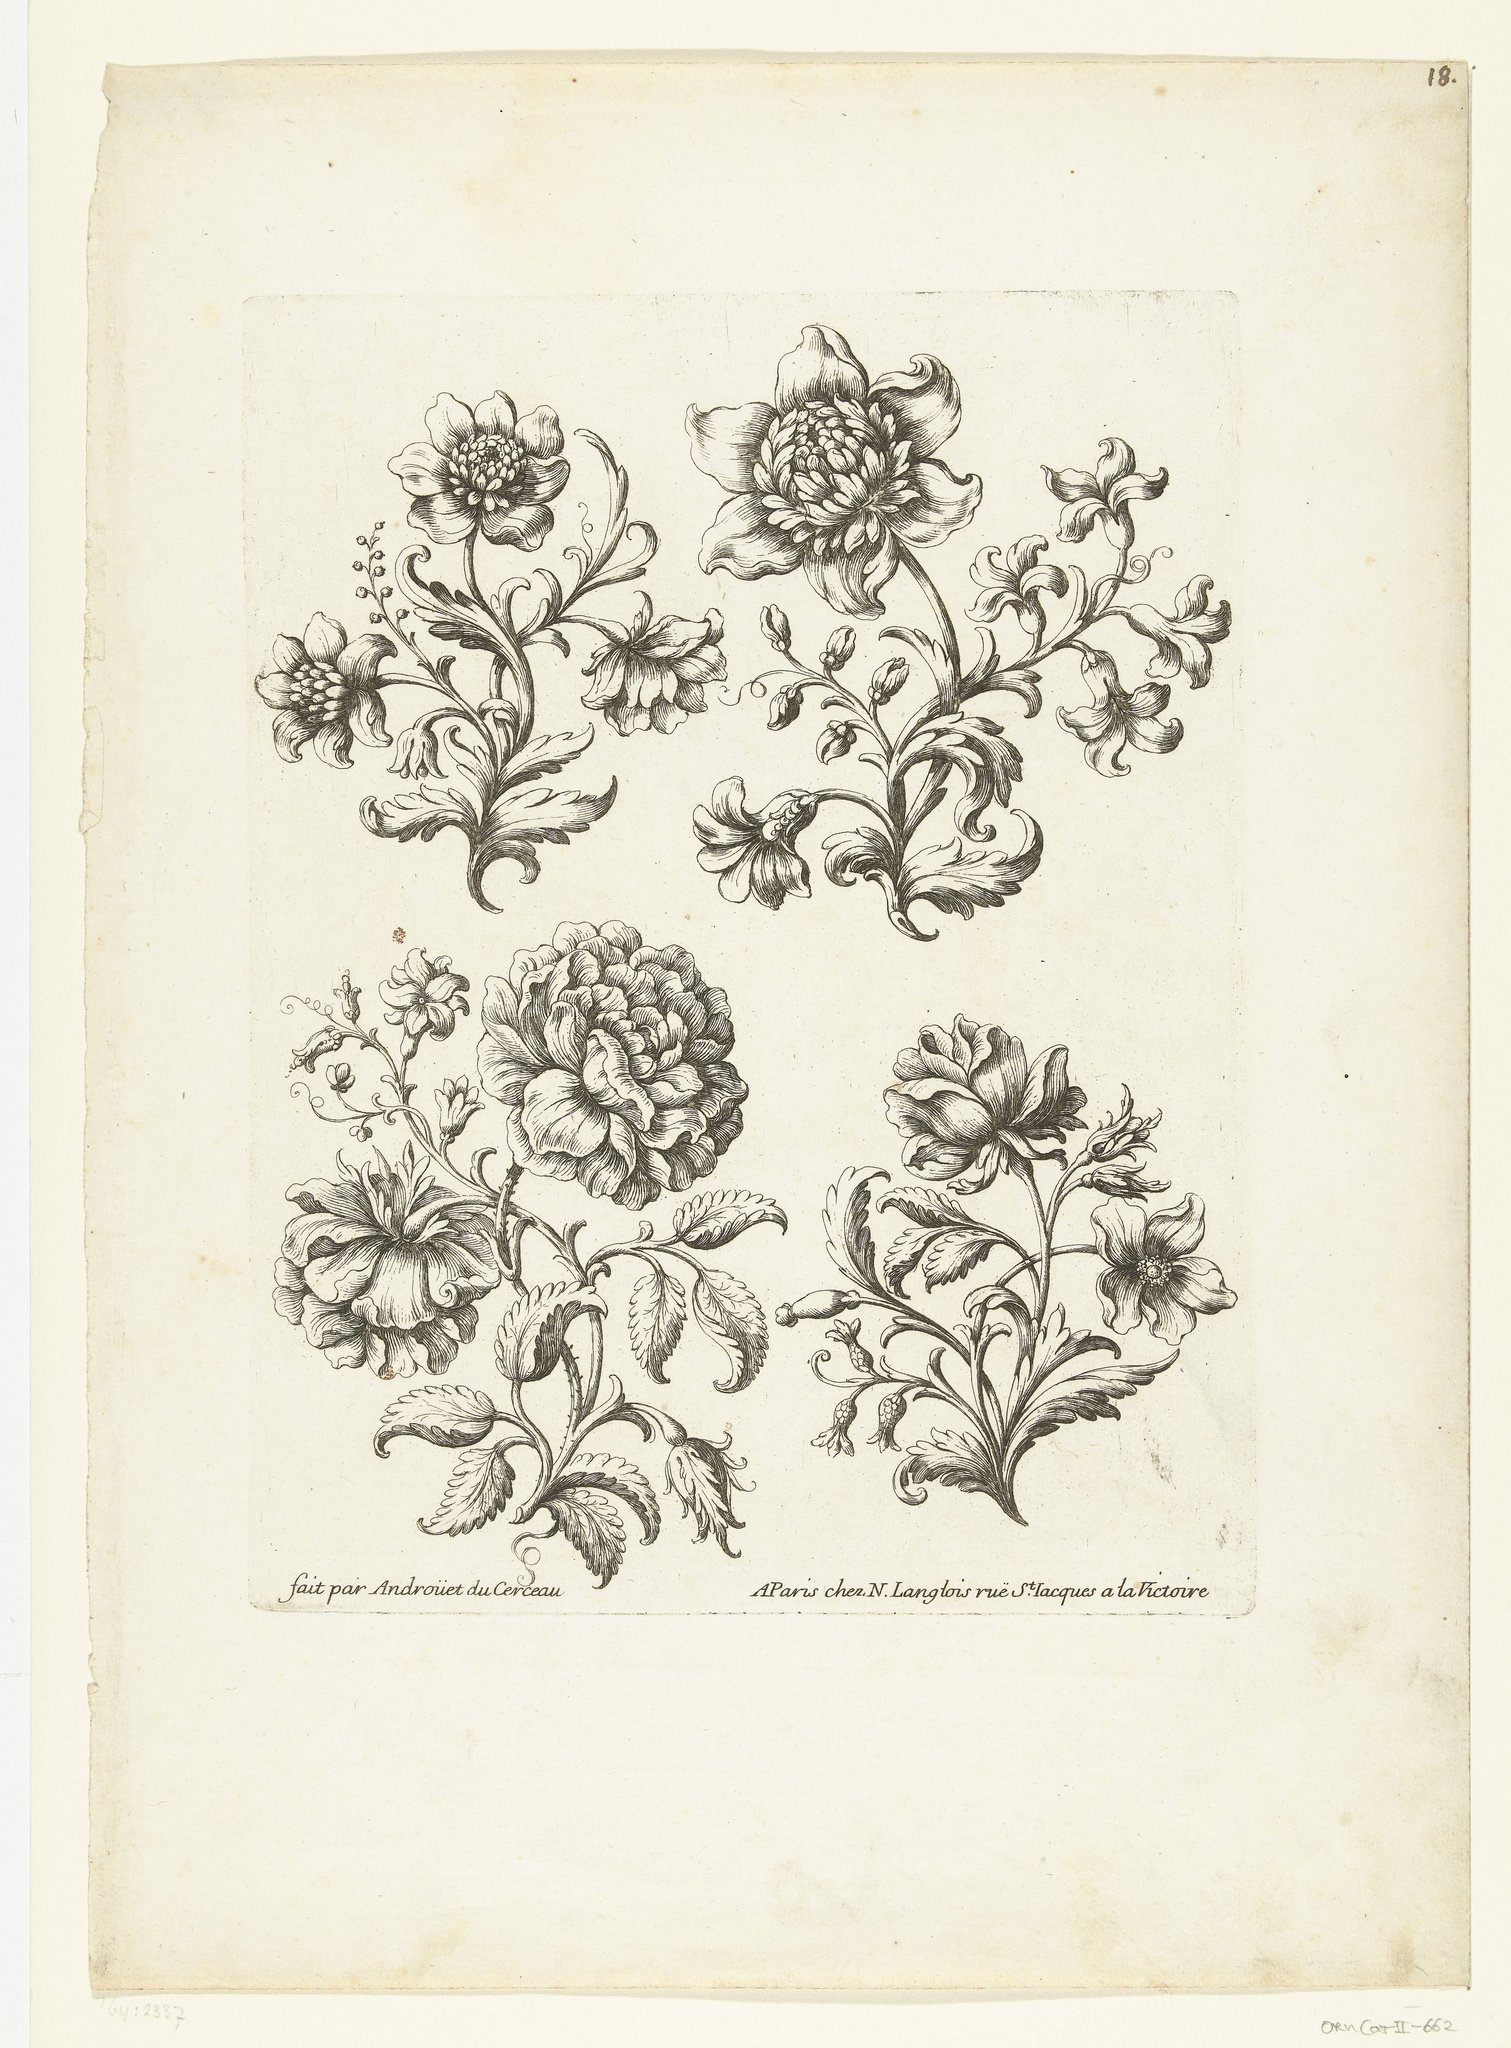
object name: ornament print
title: Vier twijgjes met bloemen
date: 1670-1685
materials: paper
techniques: etching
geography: paris